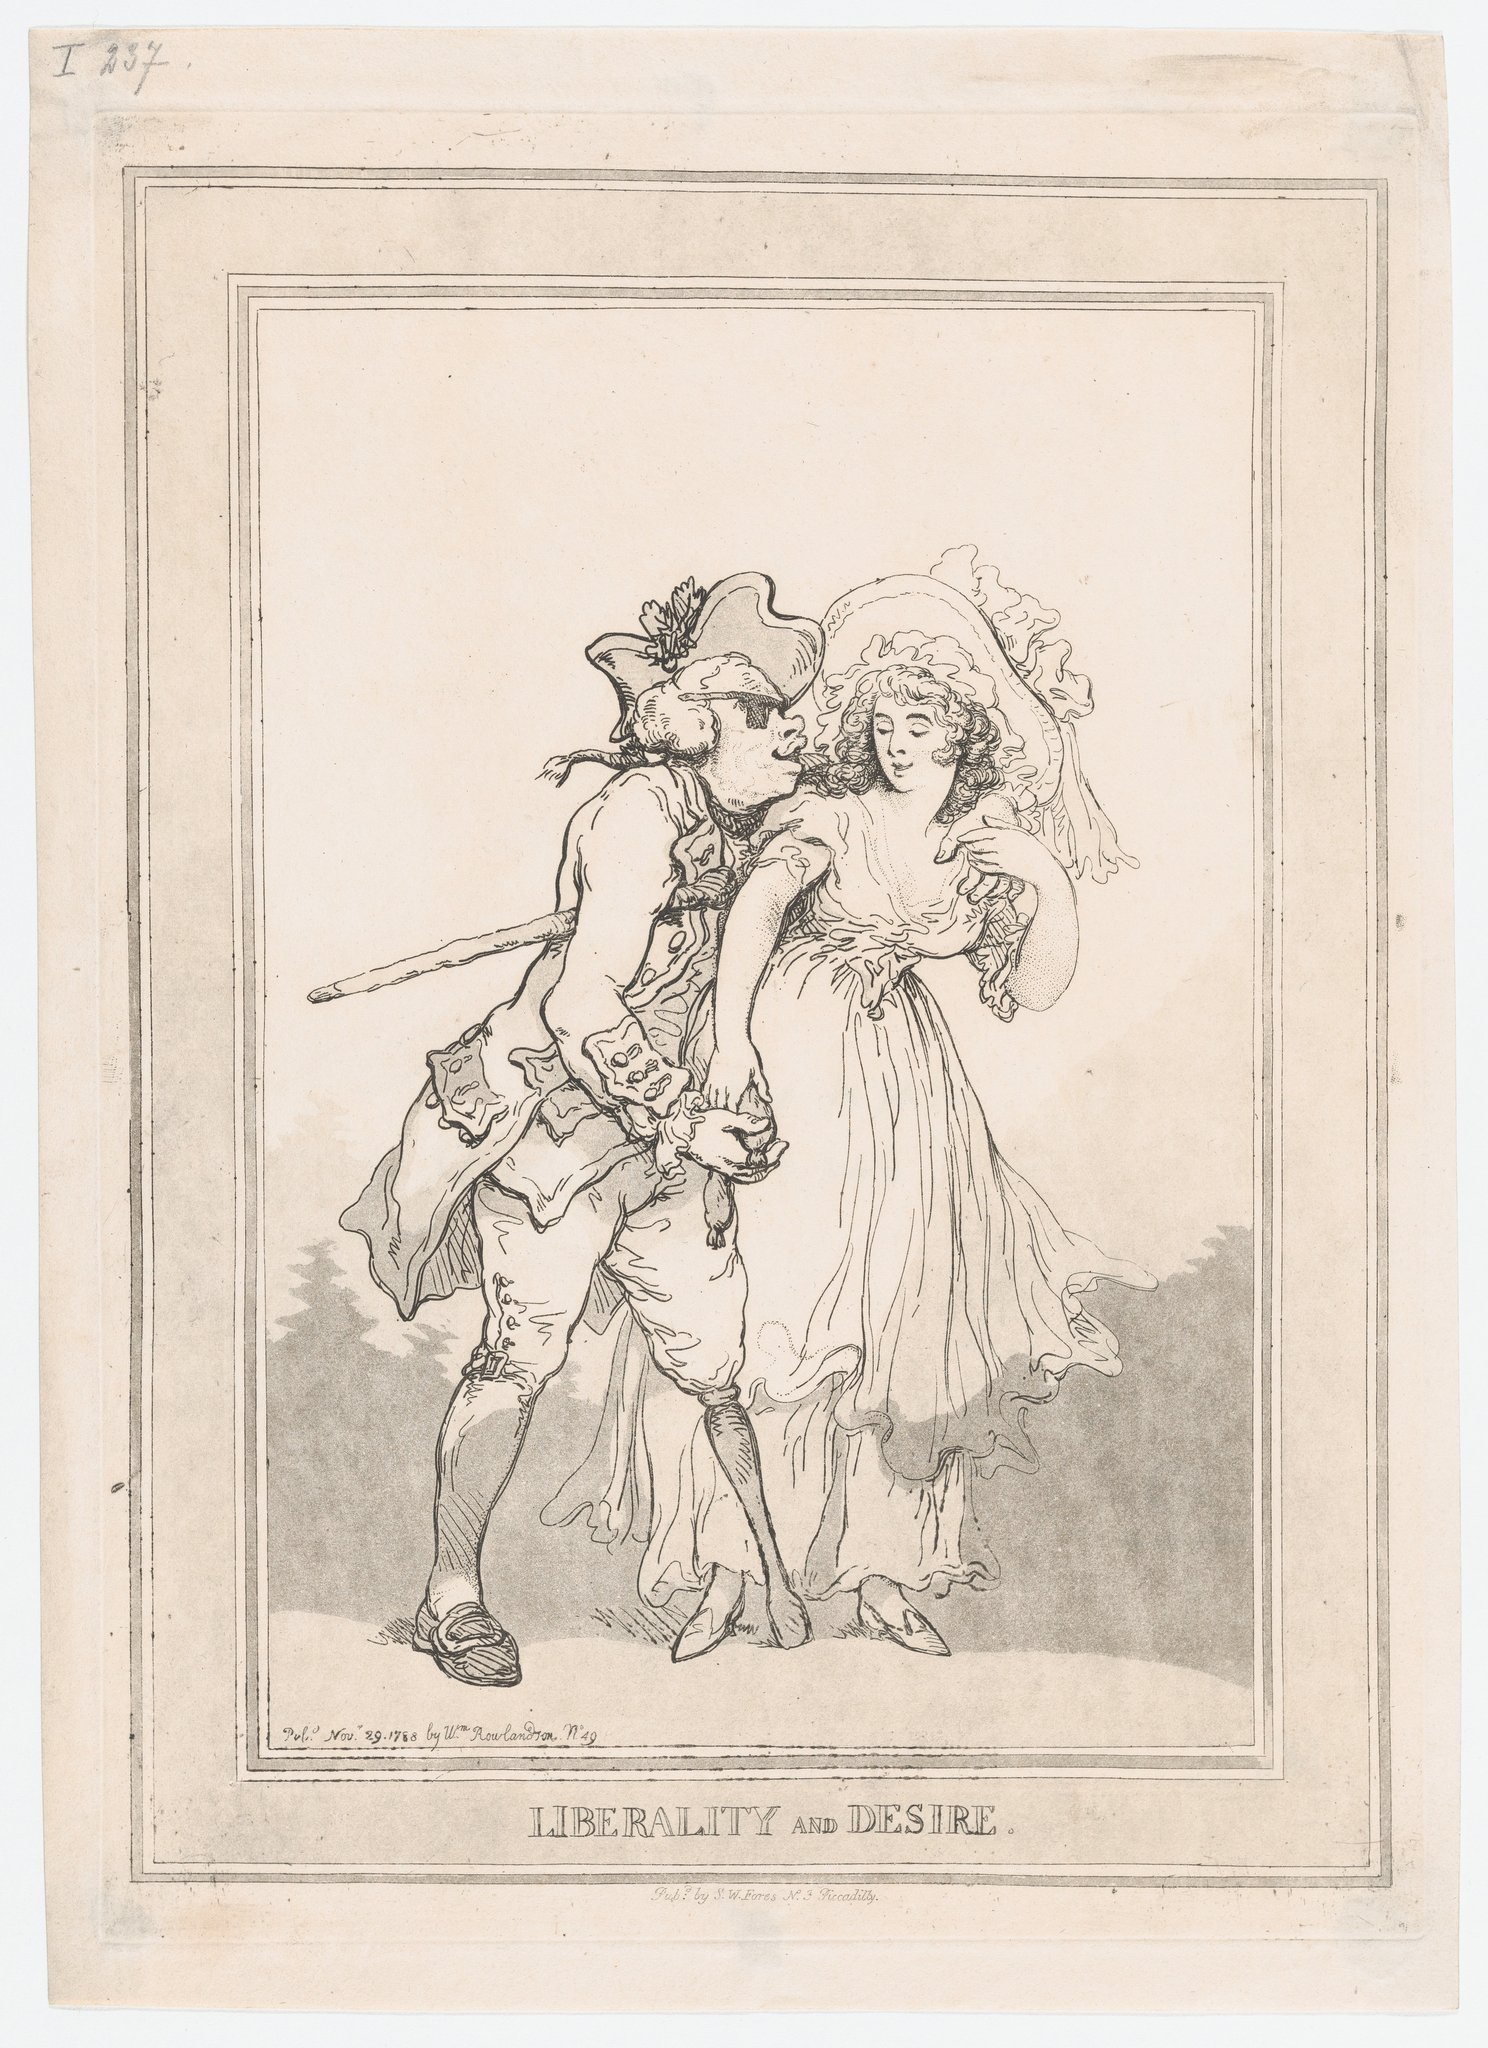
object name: print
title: Liberality and Desire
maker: thomas rowlandson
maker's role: artist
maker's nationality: british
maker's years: 1757-1827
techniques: aquatint, etching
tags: couples,men,women